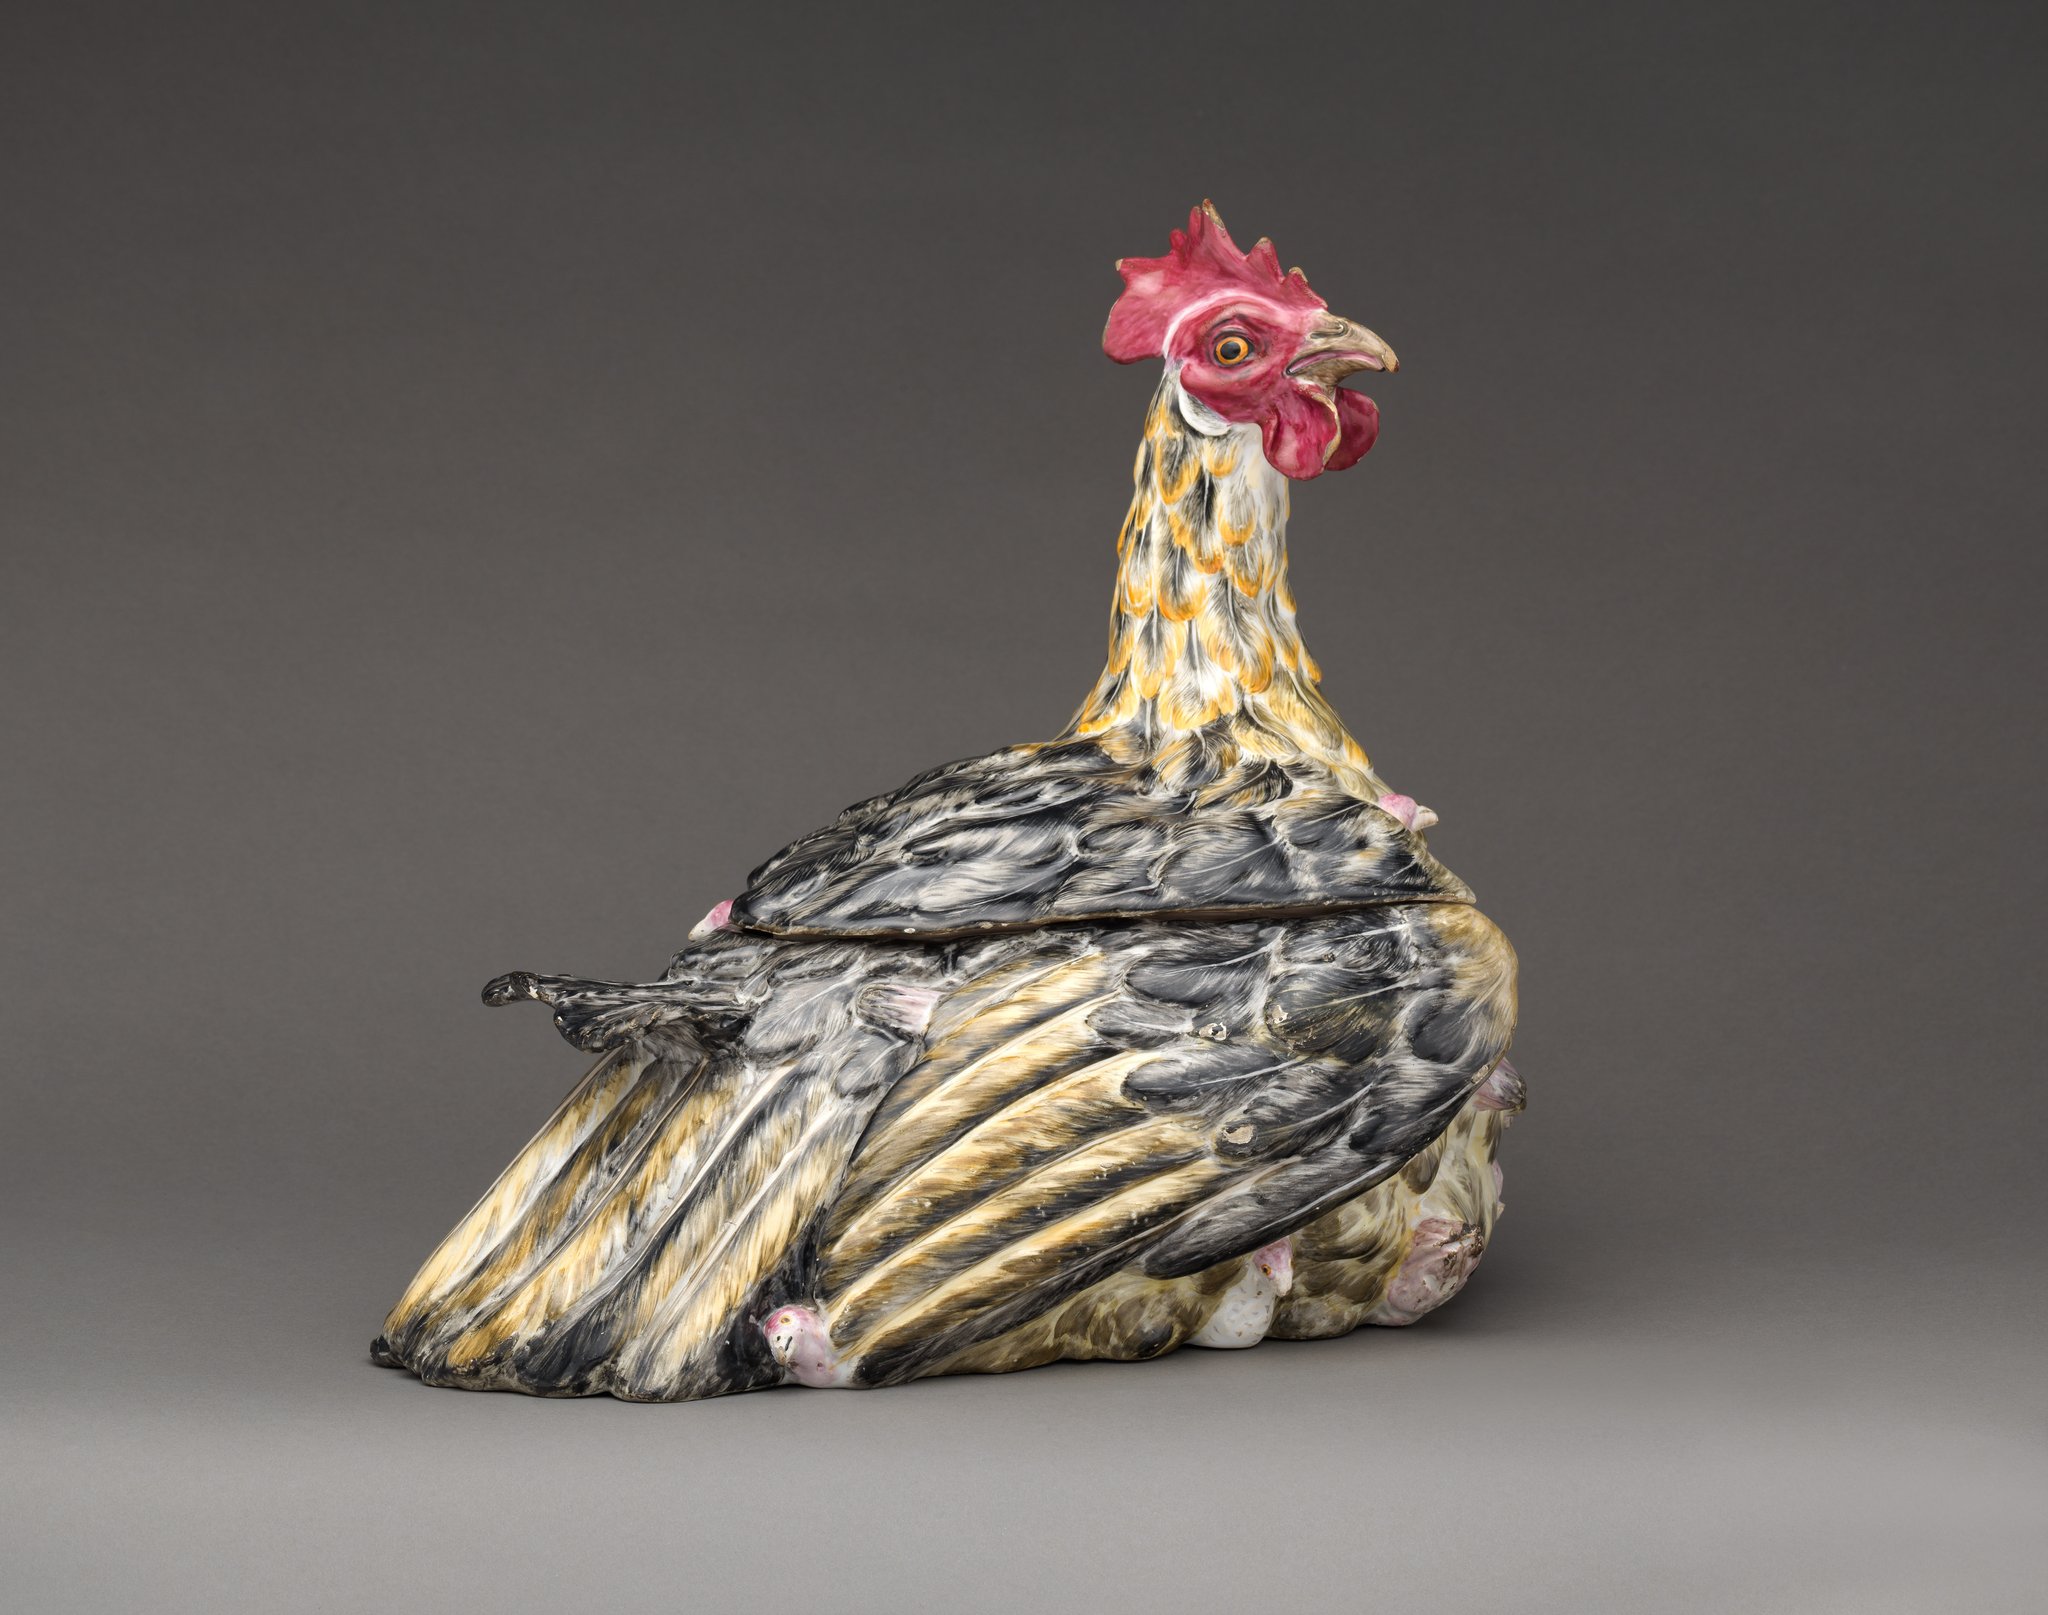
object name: tureen with cover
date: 1755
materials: faience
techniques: glazing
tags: chickens